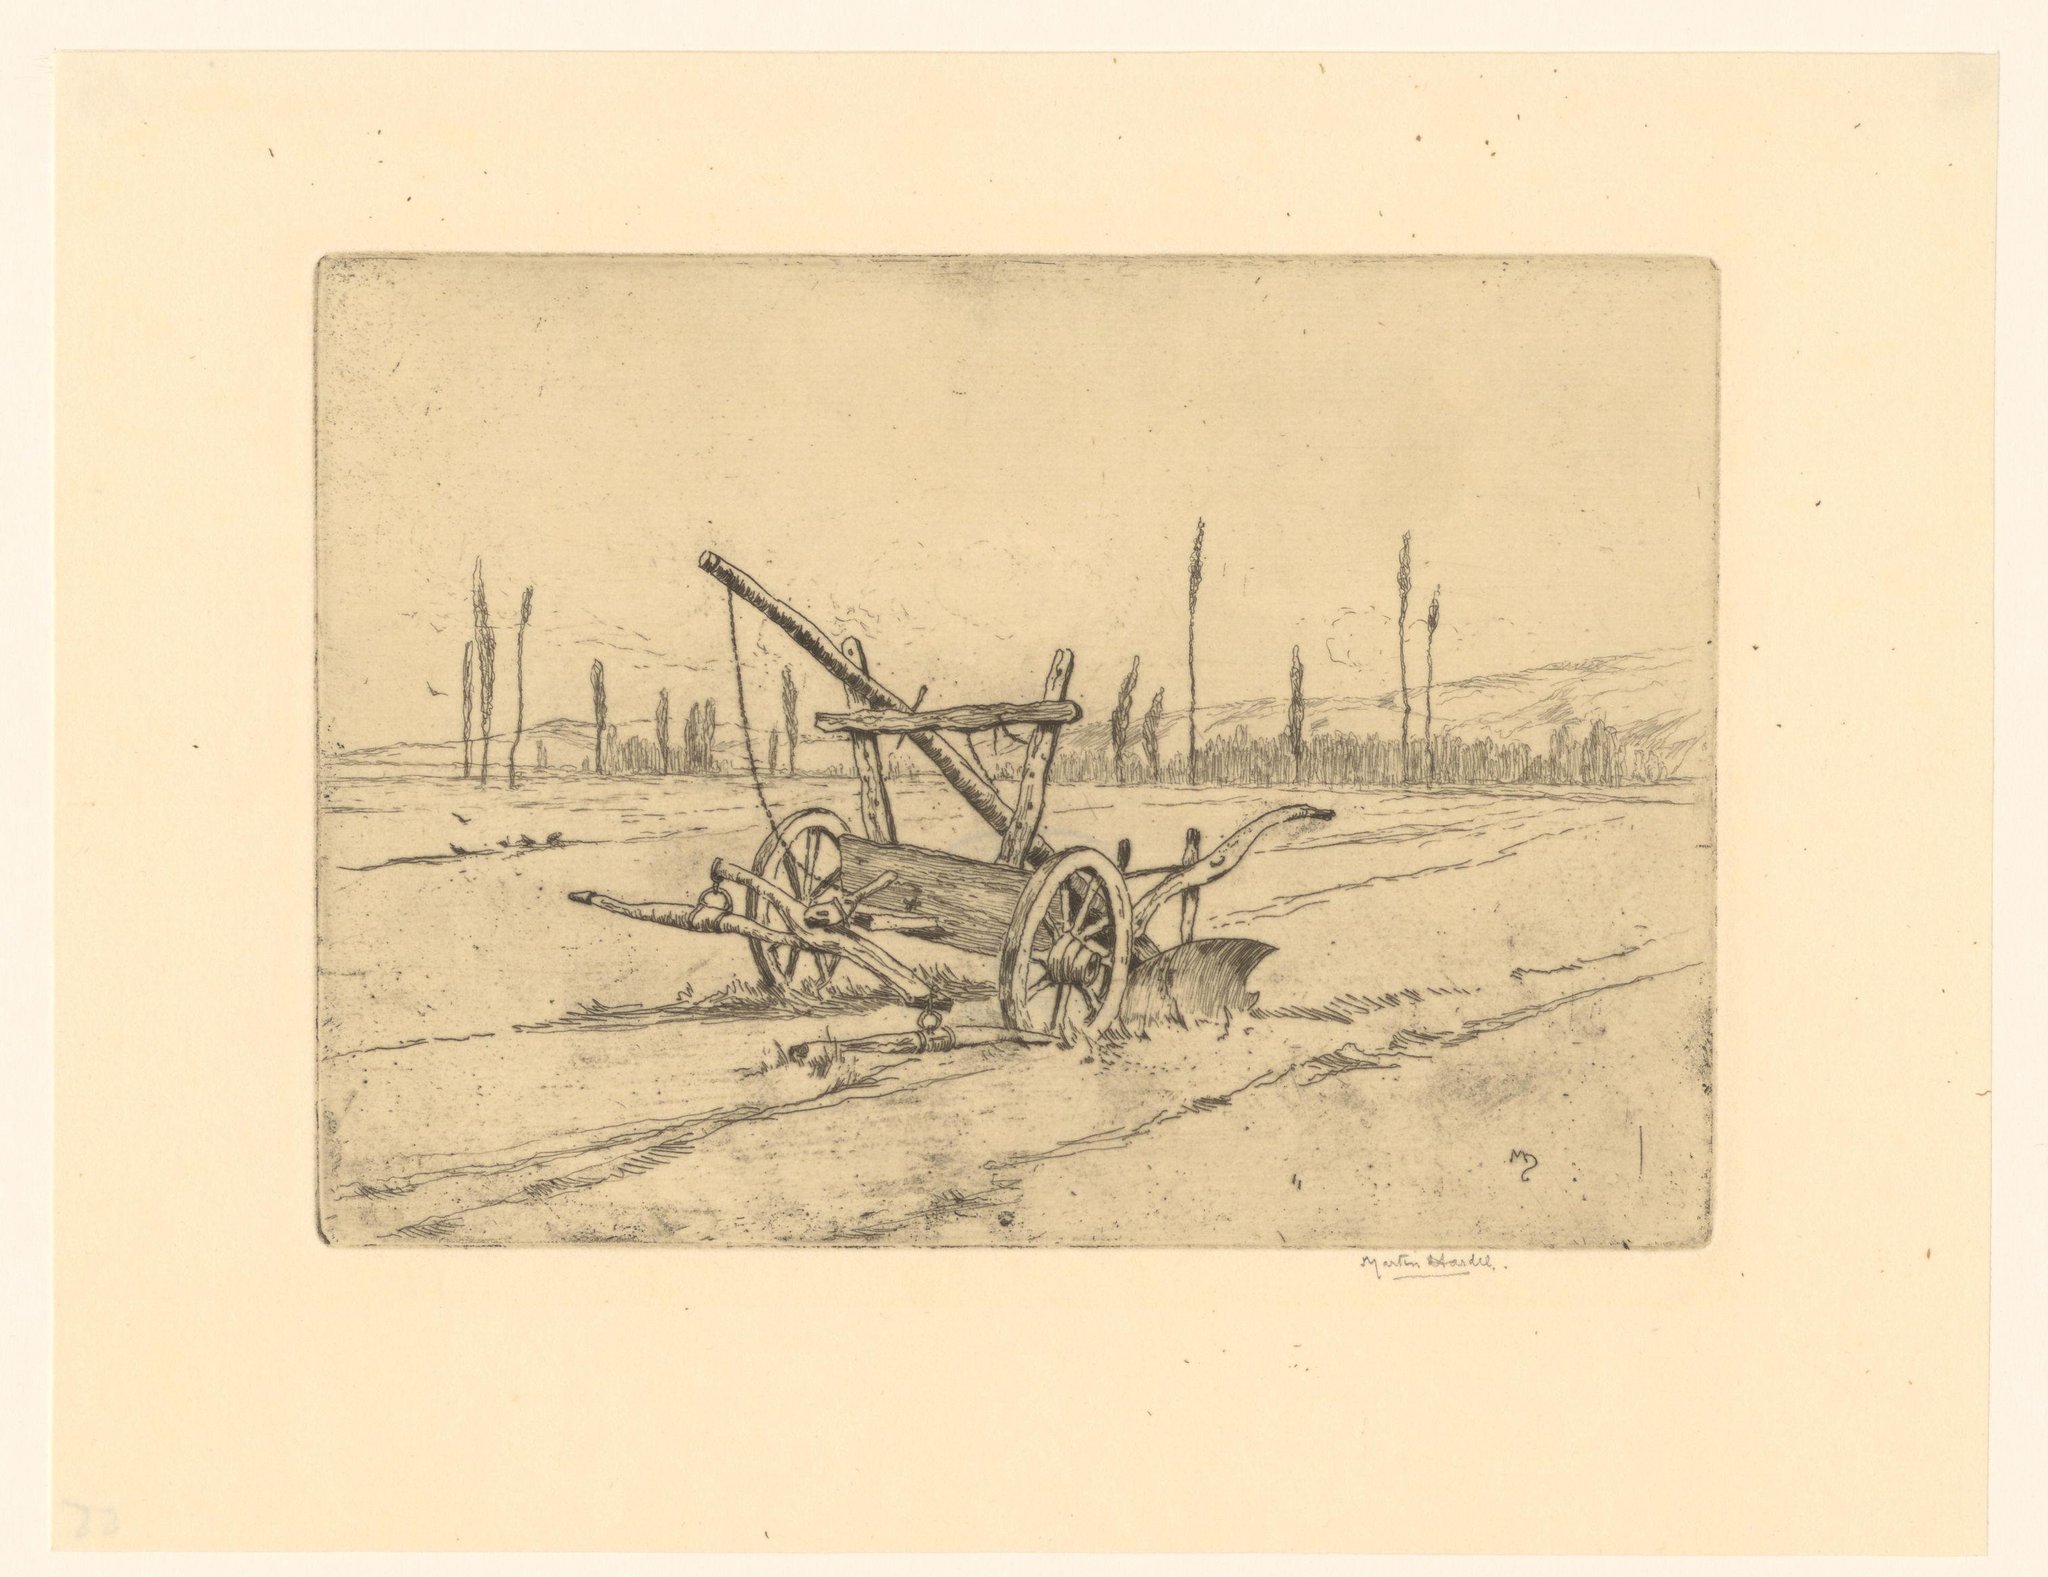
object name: print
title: A Picardy Plough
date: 1913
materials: paper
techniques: etching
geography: jumièges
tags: agricultural implements: plough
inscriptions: collector's mark: Lugt 2228, annotation: ‘Martin Hardie’, collector's mark: Lugt 2760